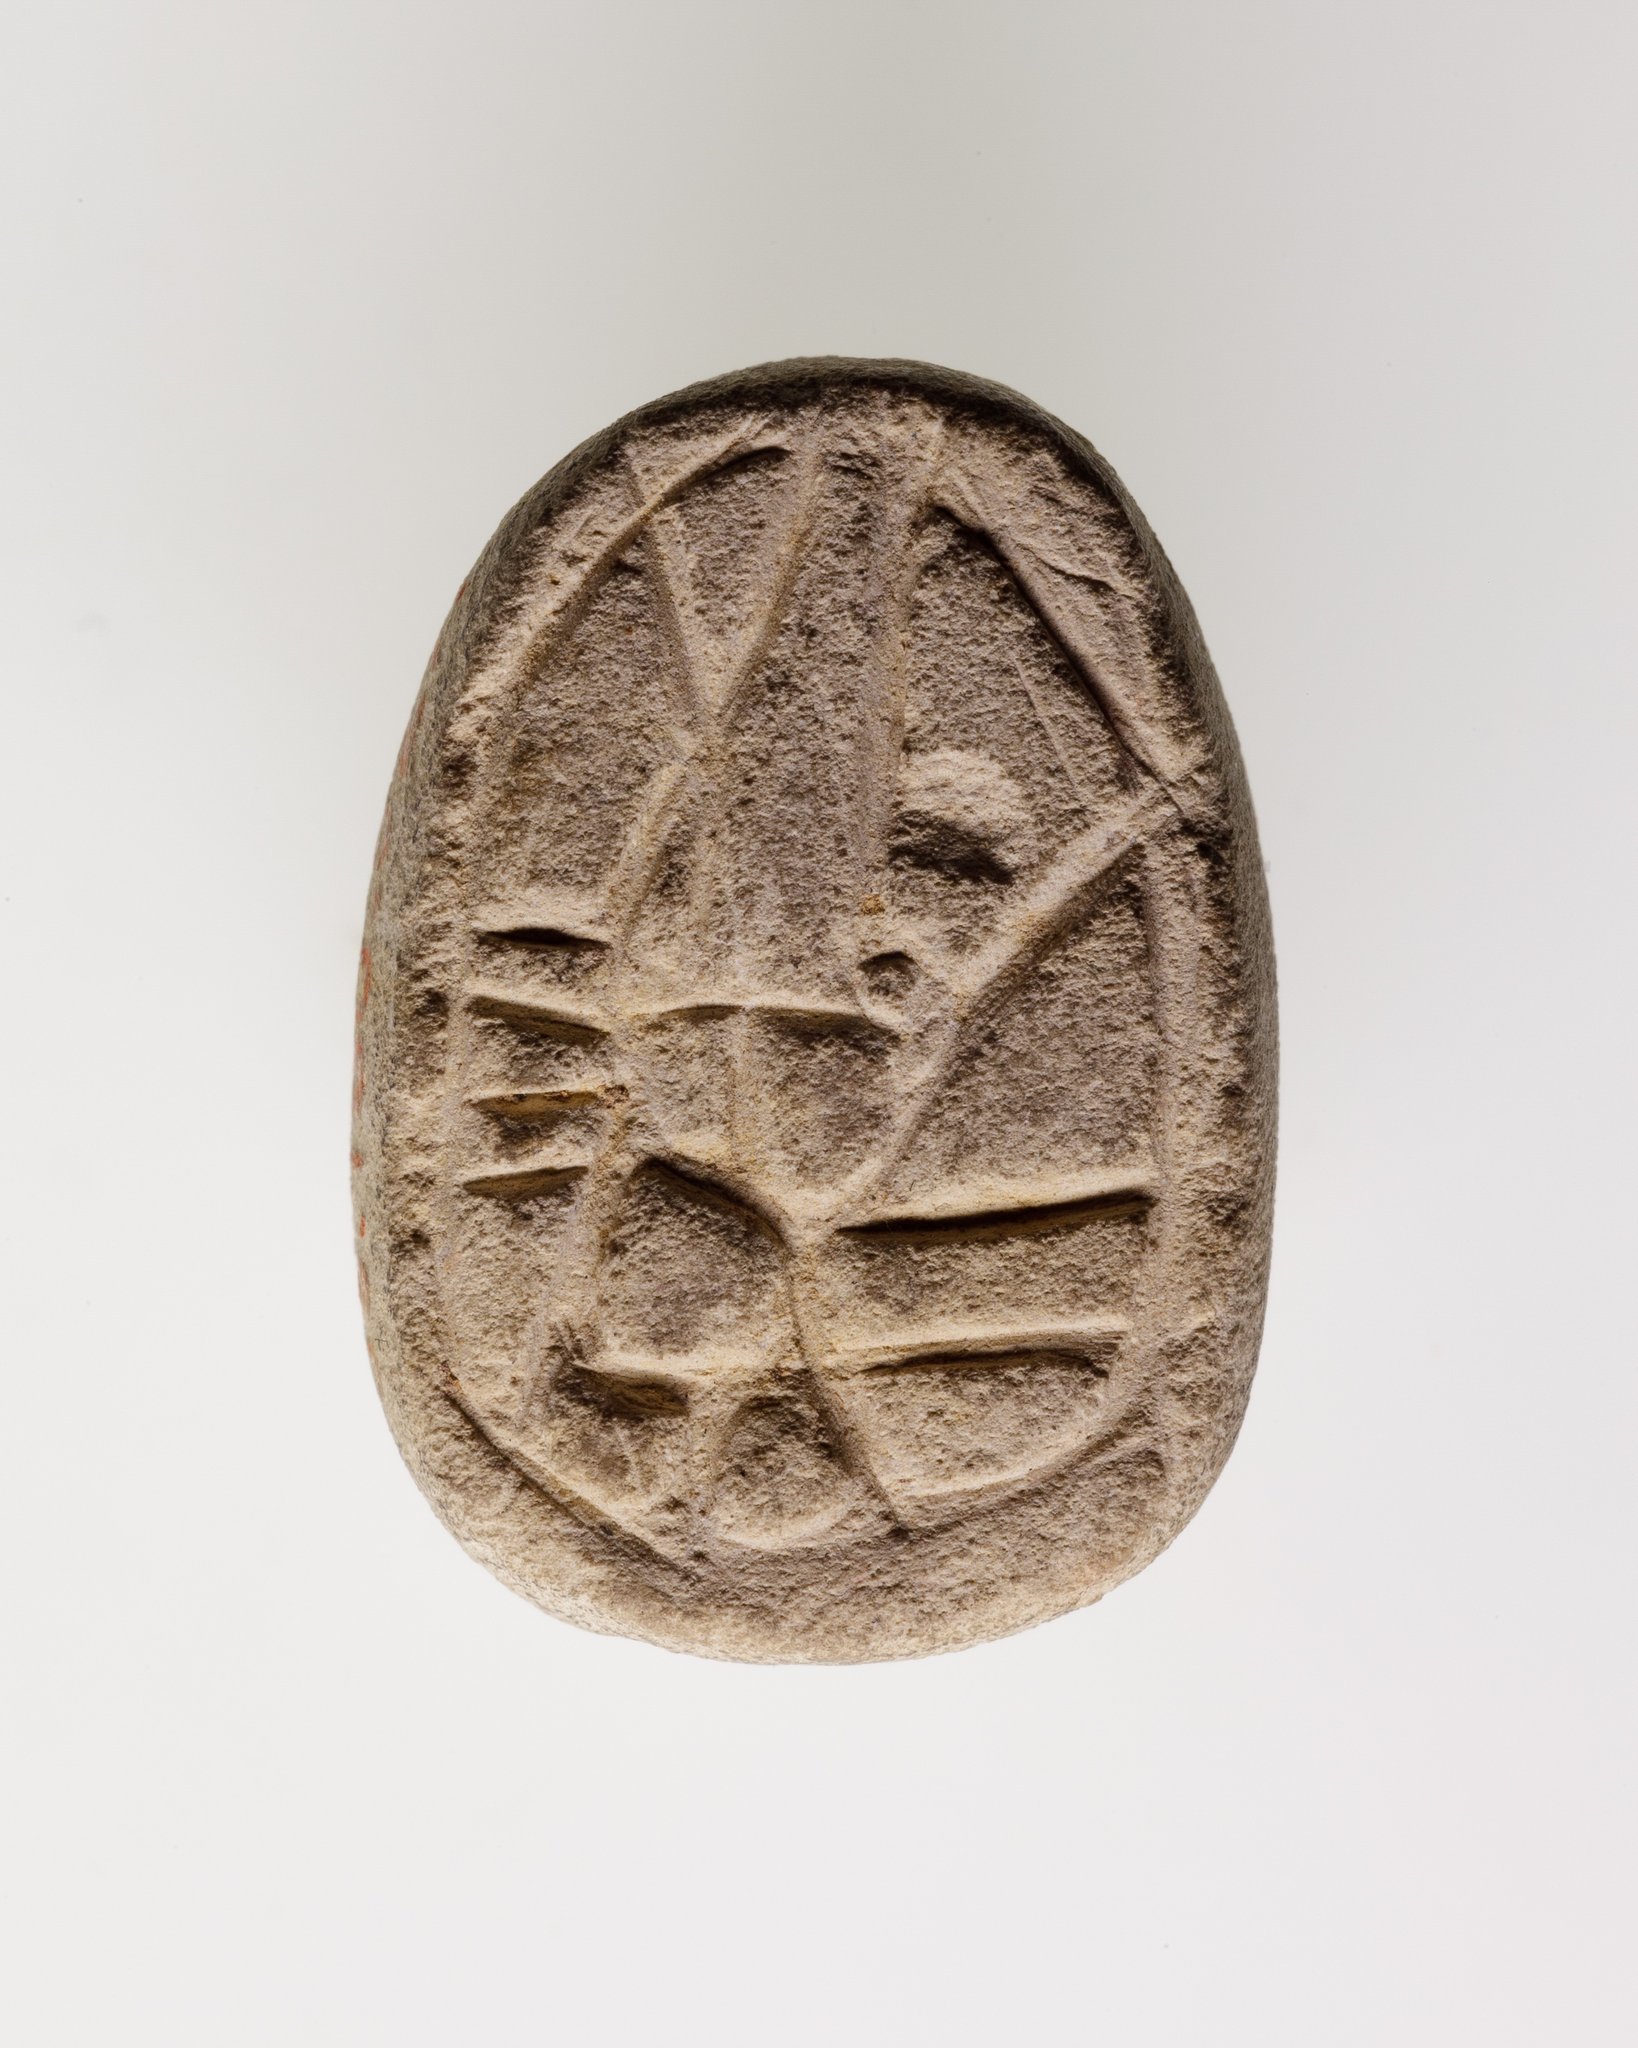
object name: scaraboid, unfinished, insect, bee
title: Unfinished Scarab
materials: limestone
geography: egypt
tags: scarabs